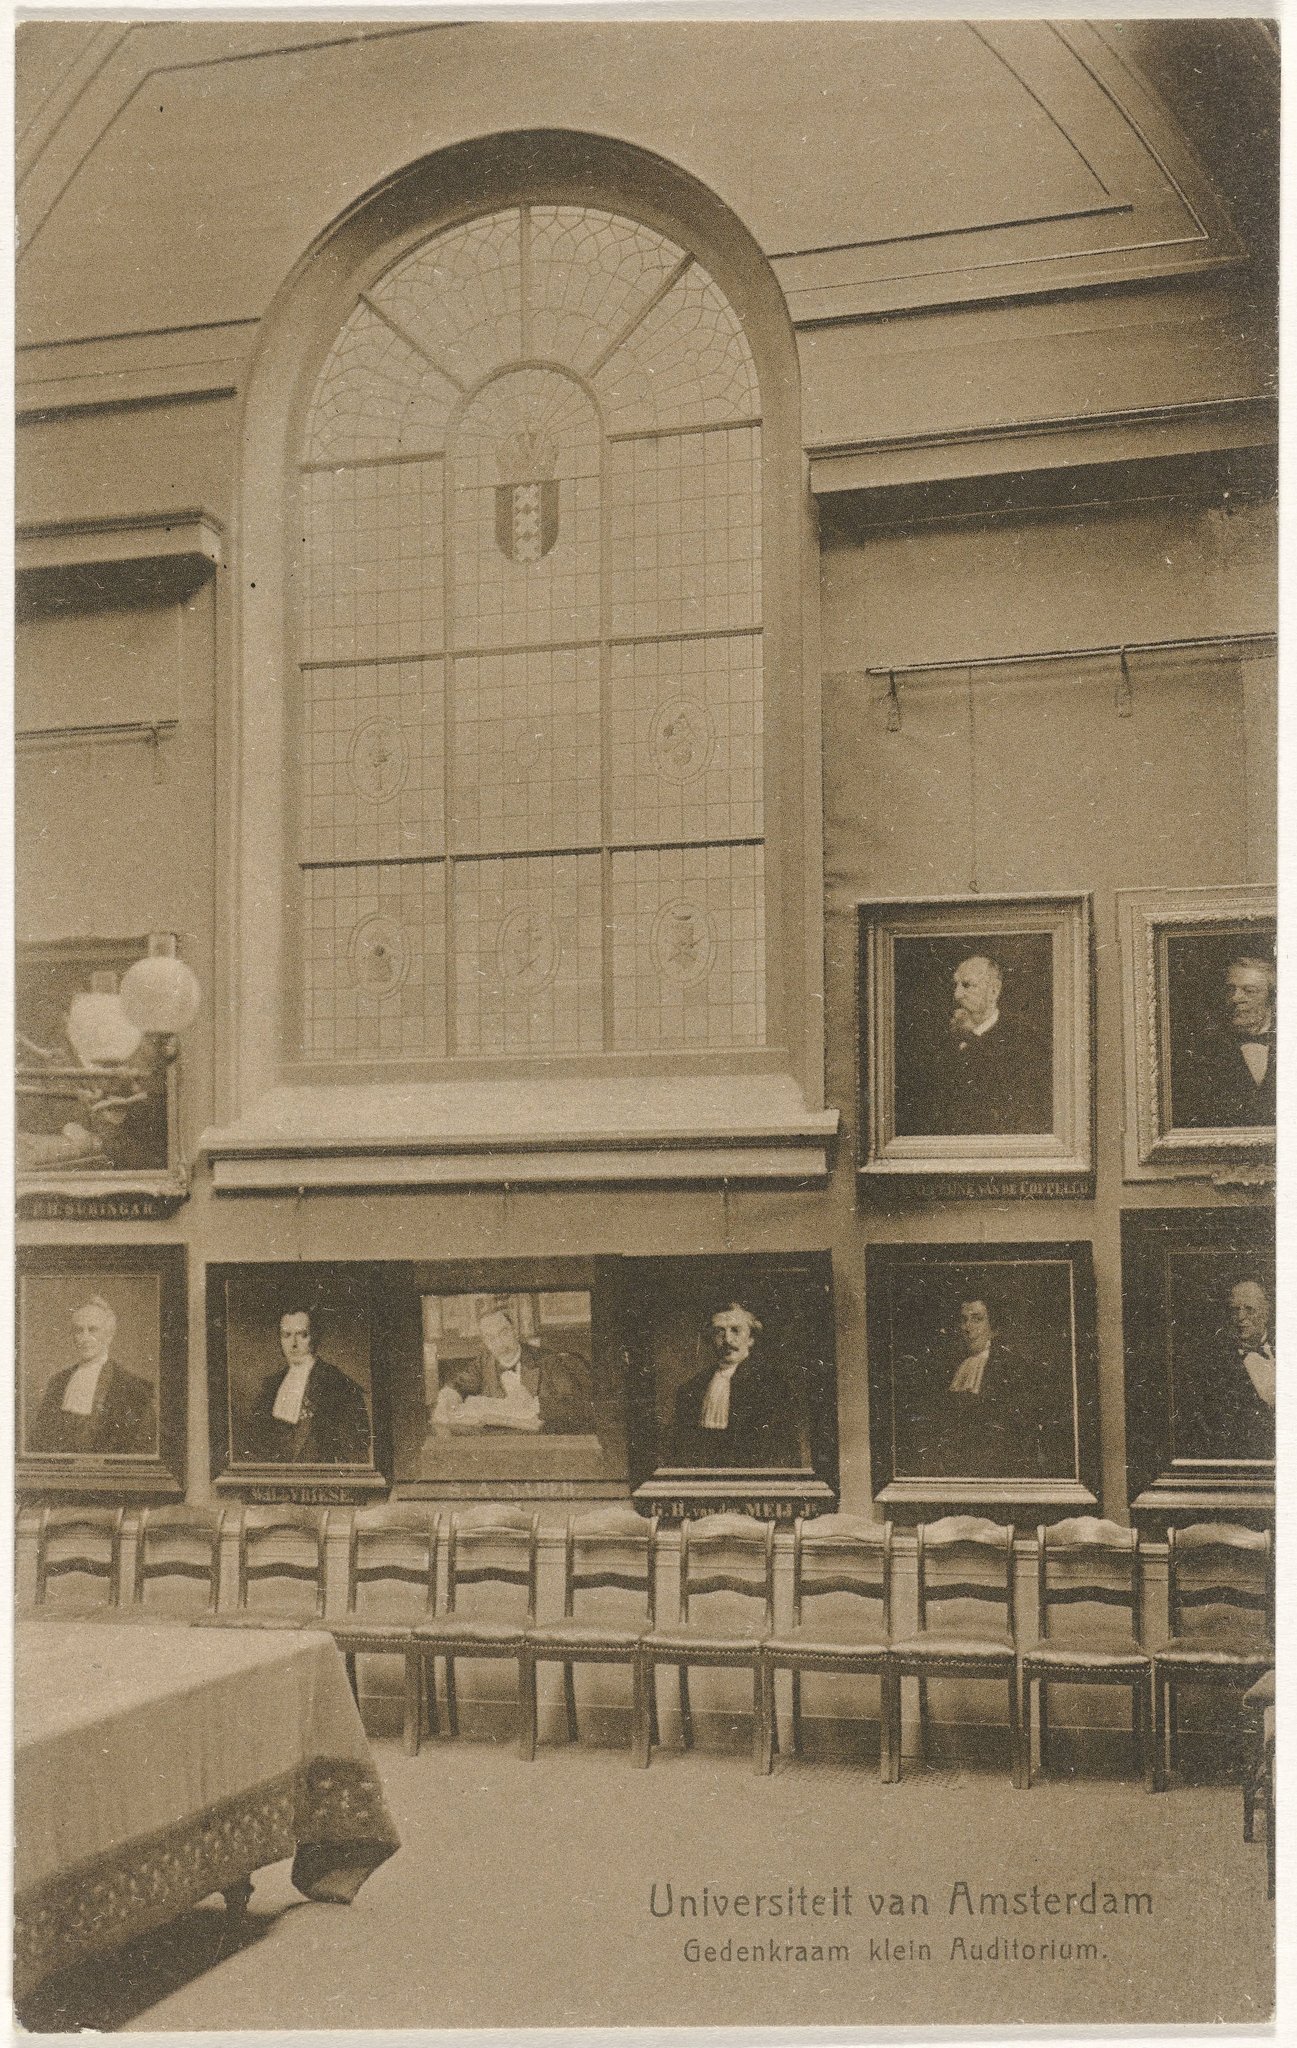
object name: photomechanical print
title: Universiteit van Amsterdam, gedenkraam klein auditorium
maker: Anonymous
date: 1907-1930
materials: cardboard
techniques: photograph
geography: amsterdam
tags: university building, college